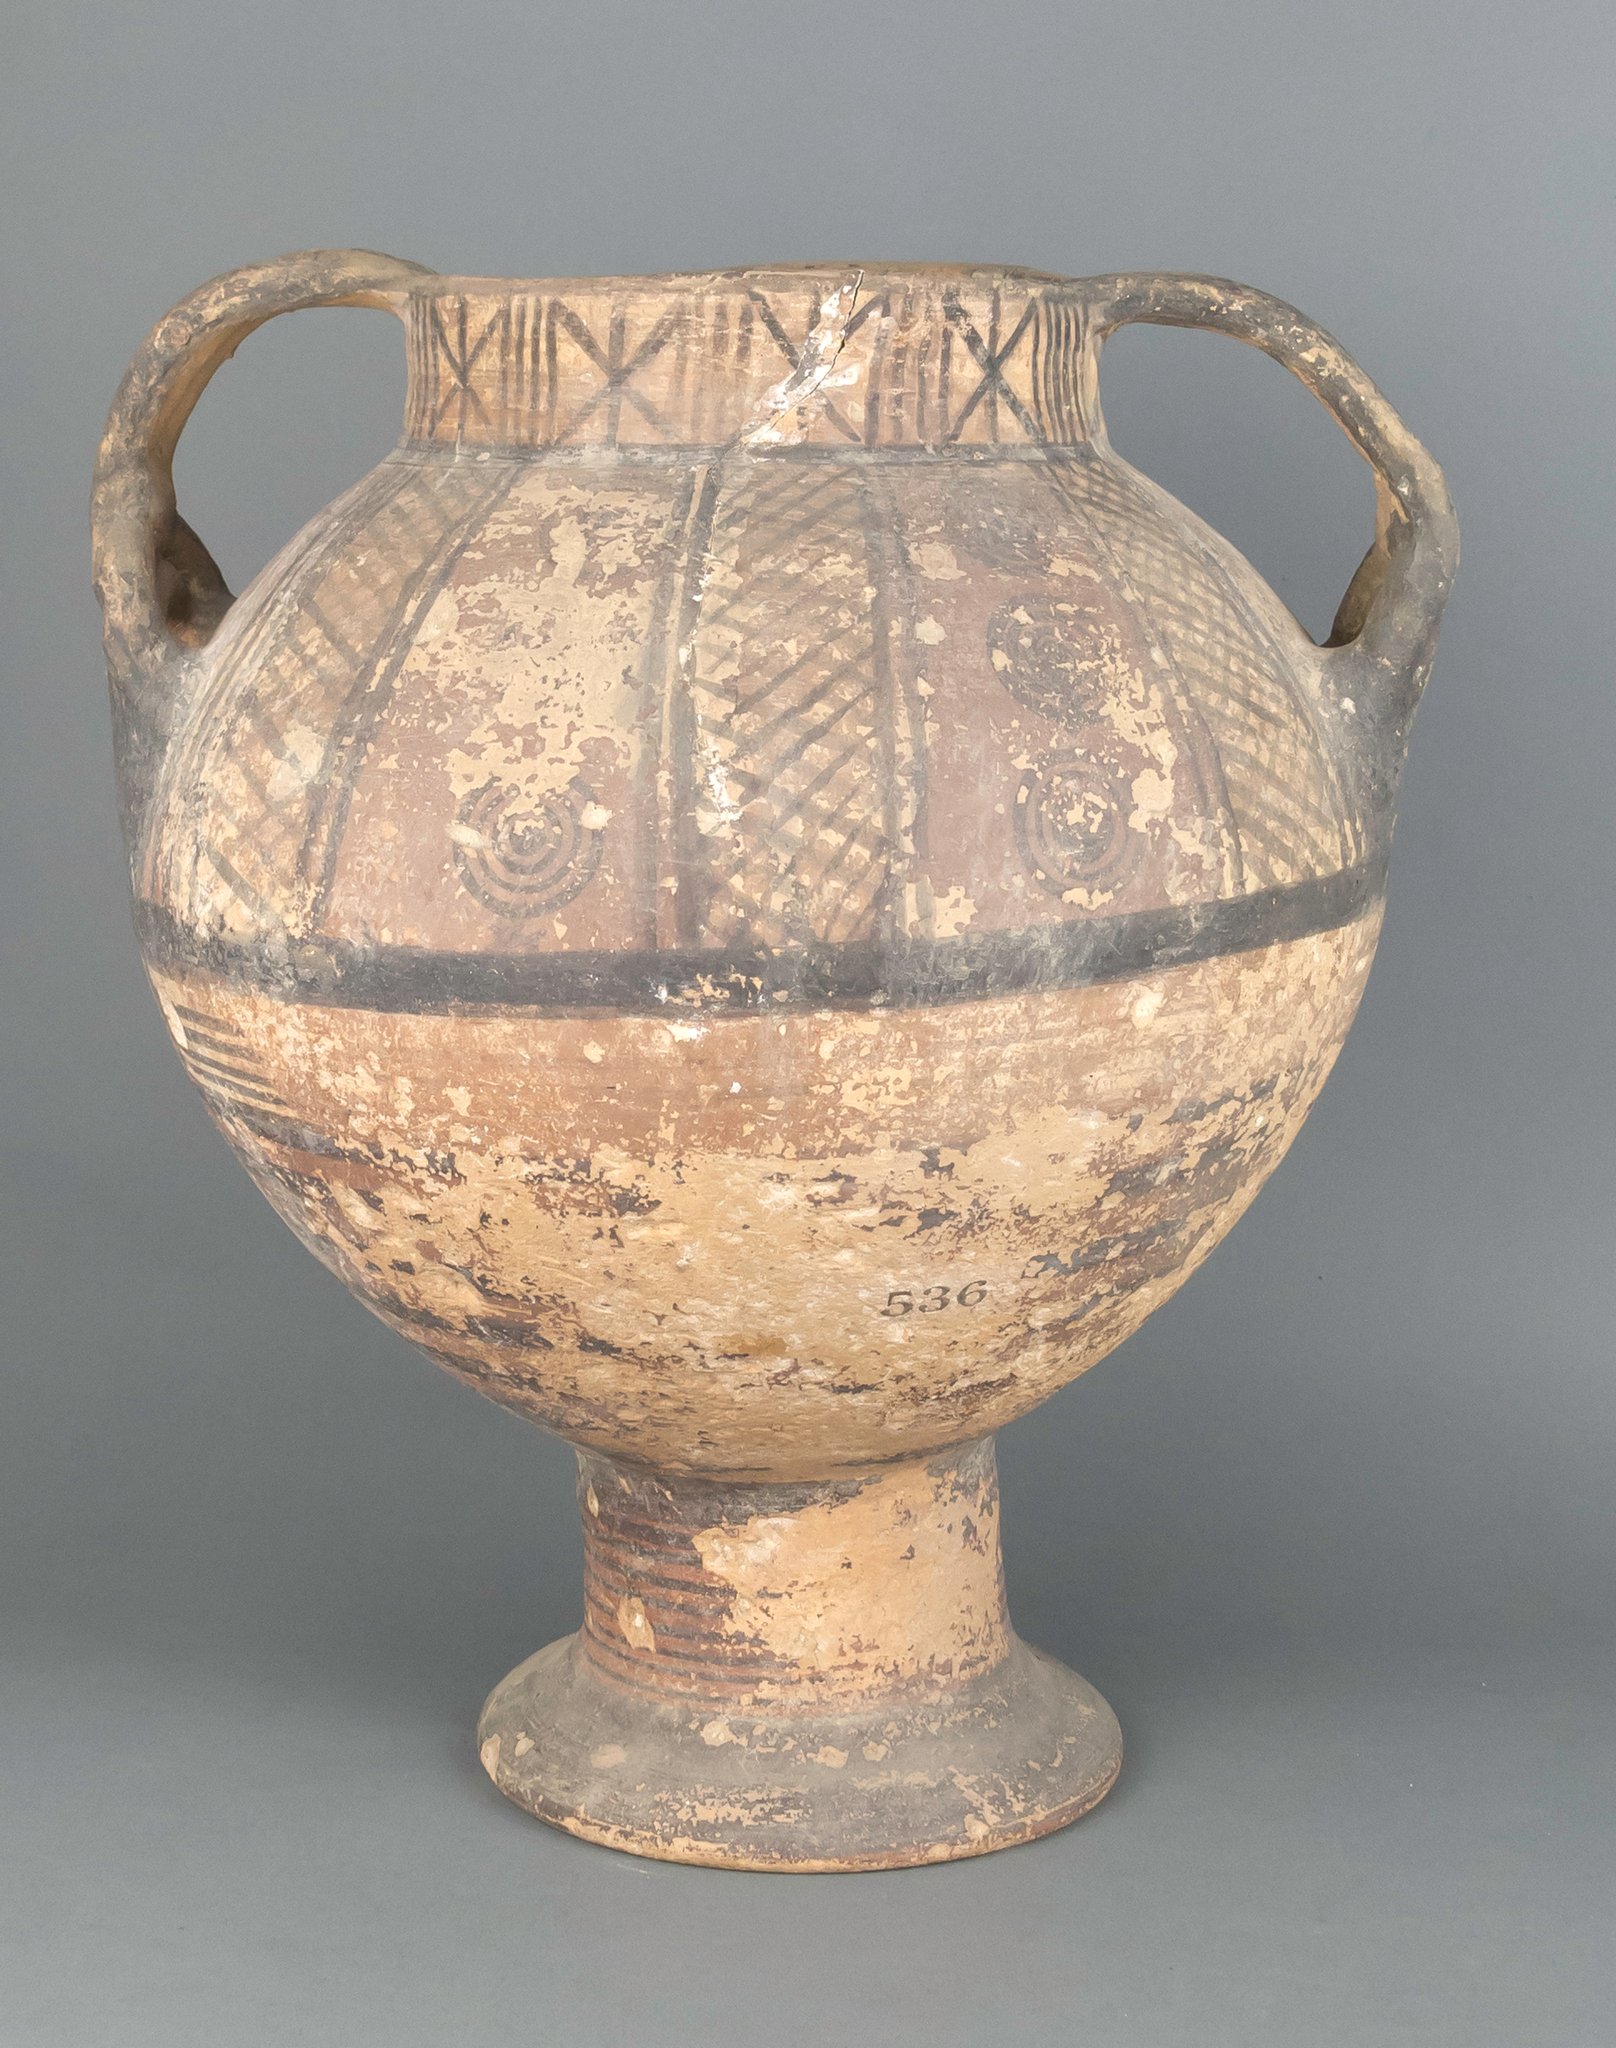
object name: amphora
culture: cypriot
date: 750-600 BCE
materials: terracotta